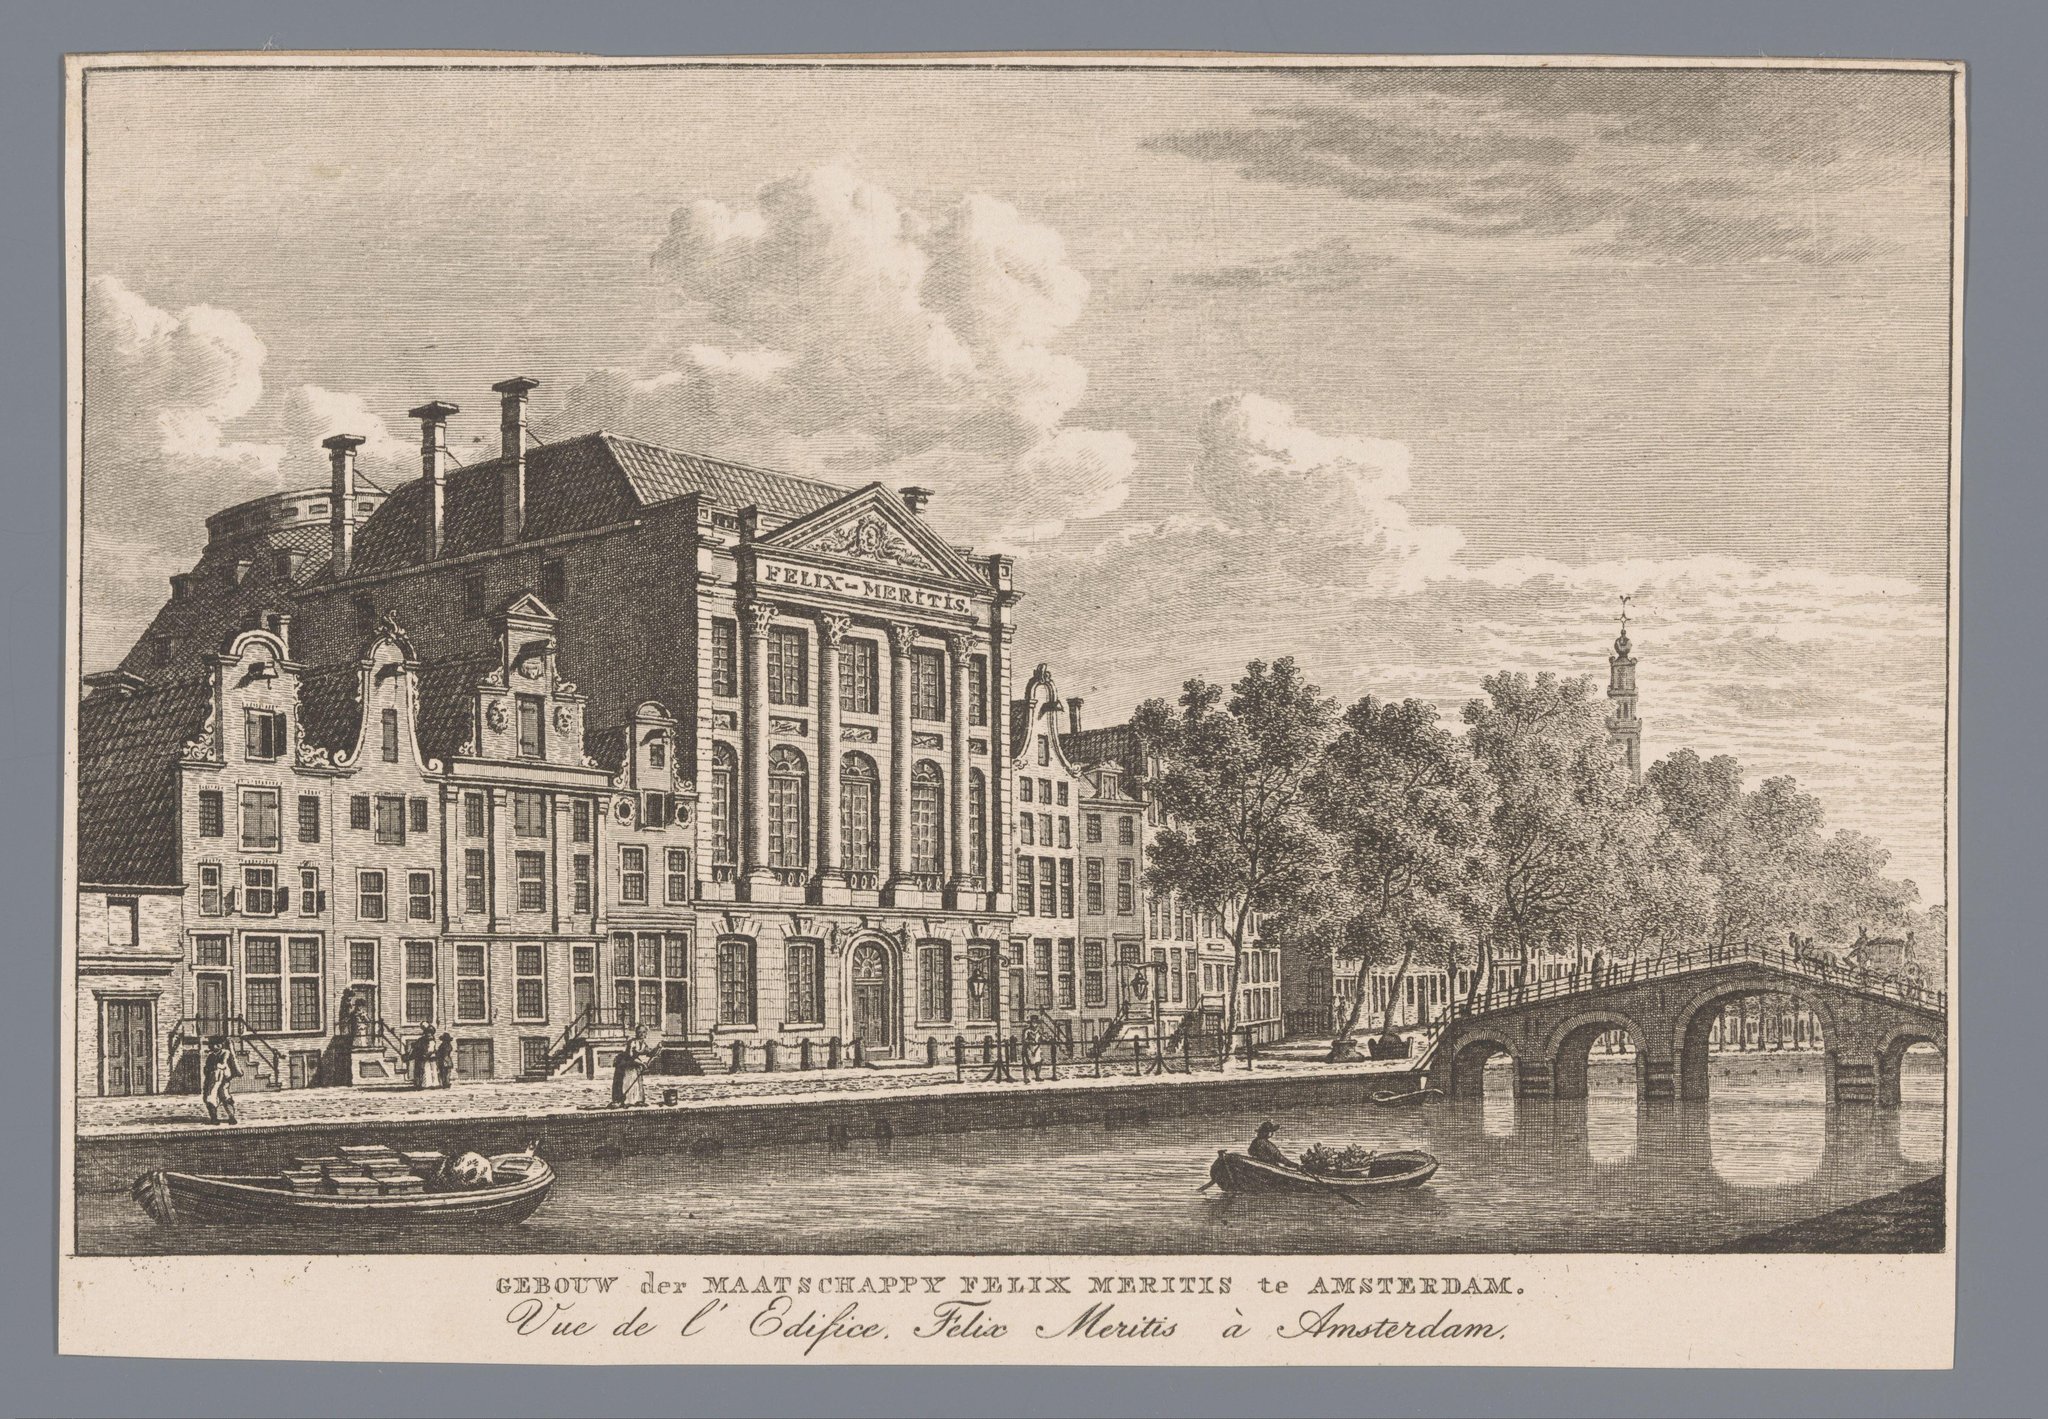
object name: print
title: Gezicht op het gebouw Felix Meritis te Amsterdam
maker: carel frederik bendorp (i)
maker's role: print maker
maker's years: 1736-1814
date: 1786-1792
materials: paper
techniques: etching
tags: urban housing, rowing-boat, canoe, etc., bridge in city across river, canal, etc.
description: Huidige staat van prent uitgegeven als onderdeel van een plaatwerk uit ca. 1824-1825 met 74 (ongenummerde) platen van de belangrijkste topografische gezichten en verschillende zeden en gewoonten in het Verenigd Koninkrijk der Nederlanden, getiteld 'Tableau des principales vues des palais et édifices : représentations et des coutumes et usages, dans les provinces septentrionales du Royaume des Pays-Bas'. Eerdere staat gebruikt in: Vaderlandsche gezichten, of afbeeldingen van den tegenwoordigen staat der Vereenigde Nederlanden (…). Amsterdam: Hendrik Gartman, Willem Vermandel en Jan Willem Smit, 1786-1792. Uitgegeven in afleveringen met ieder een eigen bifolium en inhoudsopgave. Alle prenten in deze publicatie zijn gegraveerd door Carel Frederik Bendorp (I) en, in de meeste gevallen, gebaseerd op tekeningen van Jan Bulthuis.